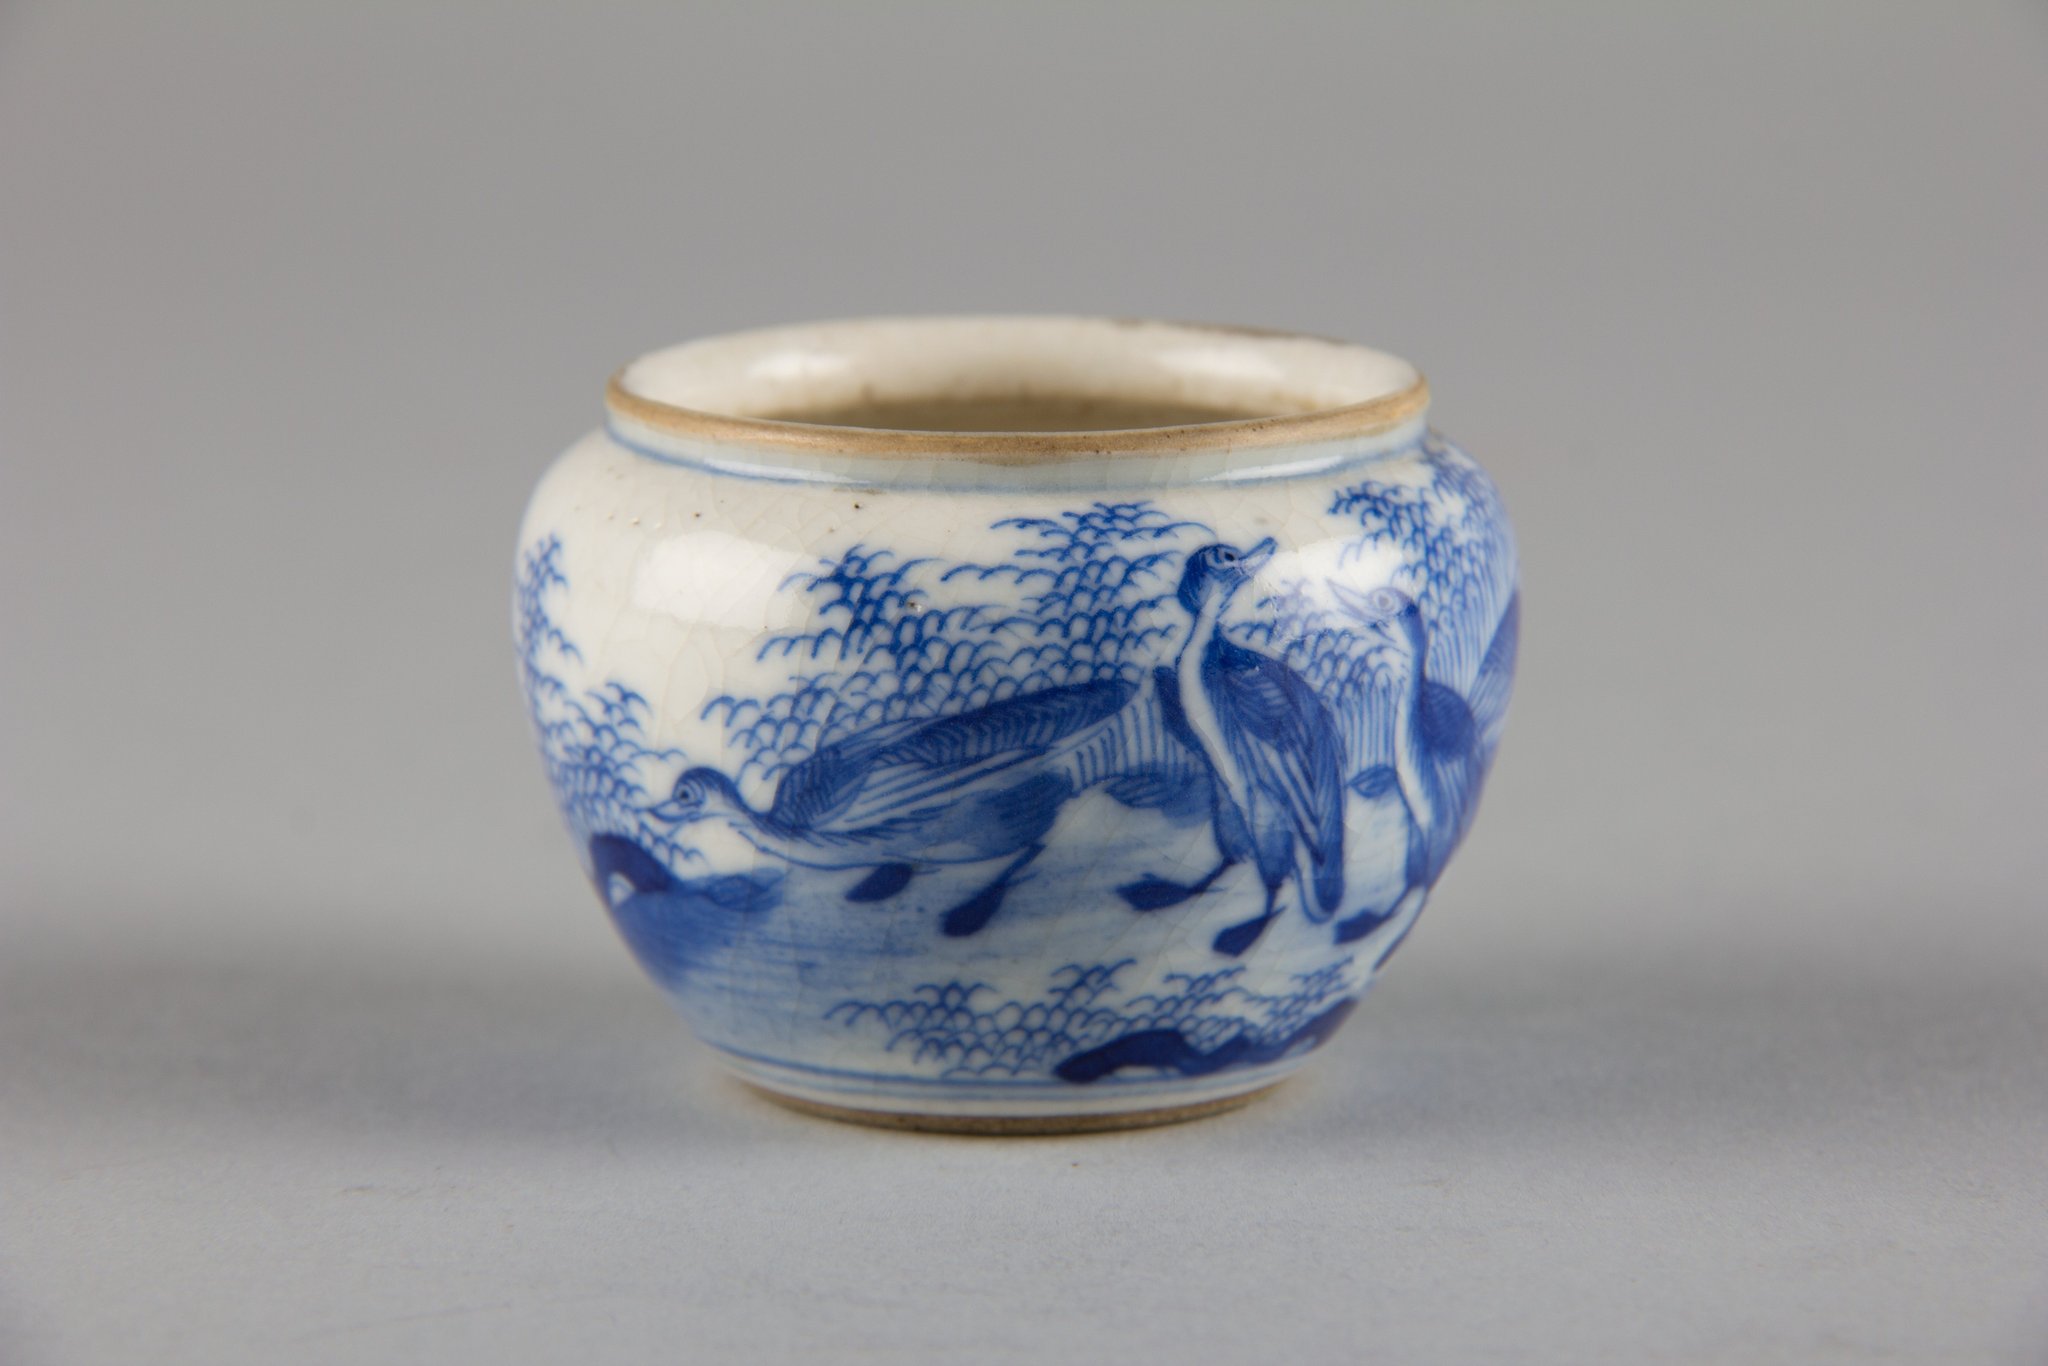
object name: bird feeder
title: Bird feeder with geese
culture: chinese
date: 1701-1800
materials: cobalt, soft paste porcelain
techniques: painting, underglaze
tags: geese